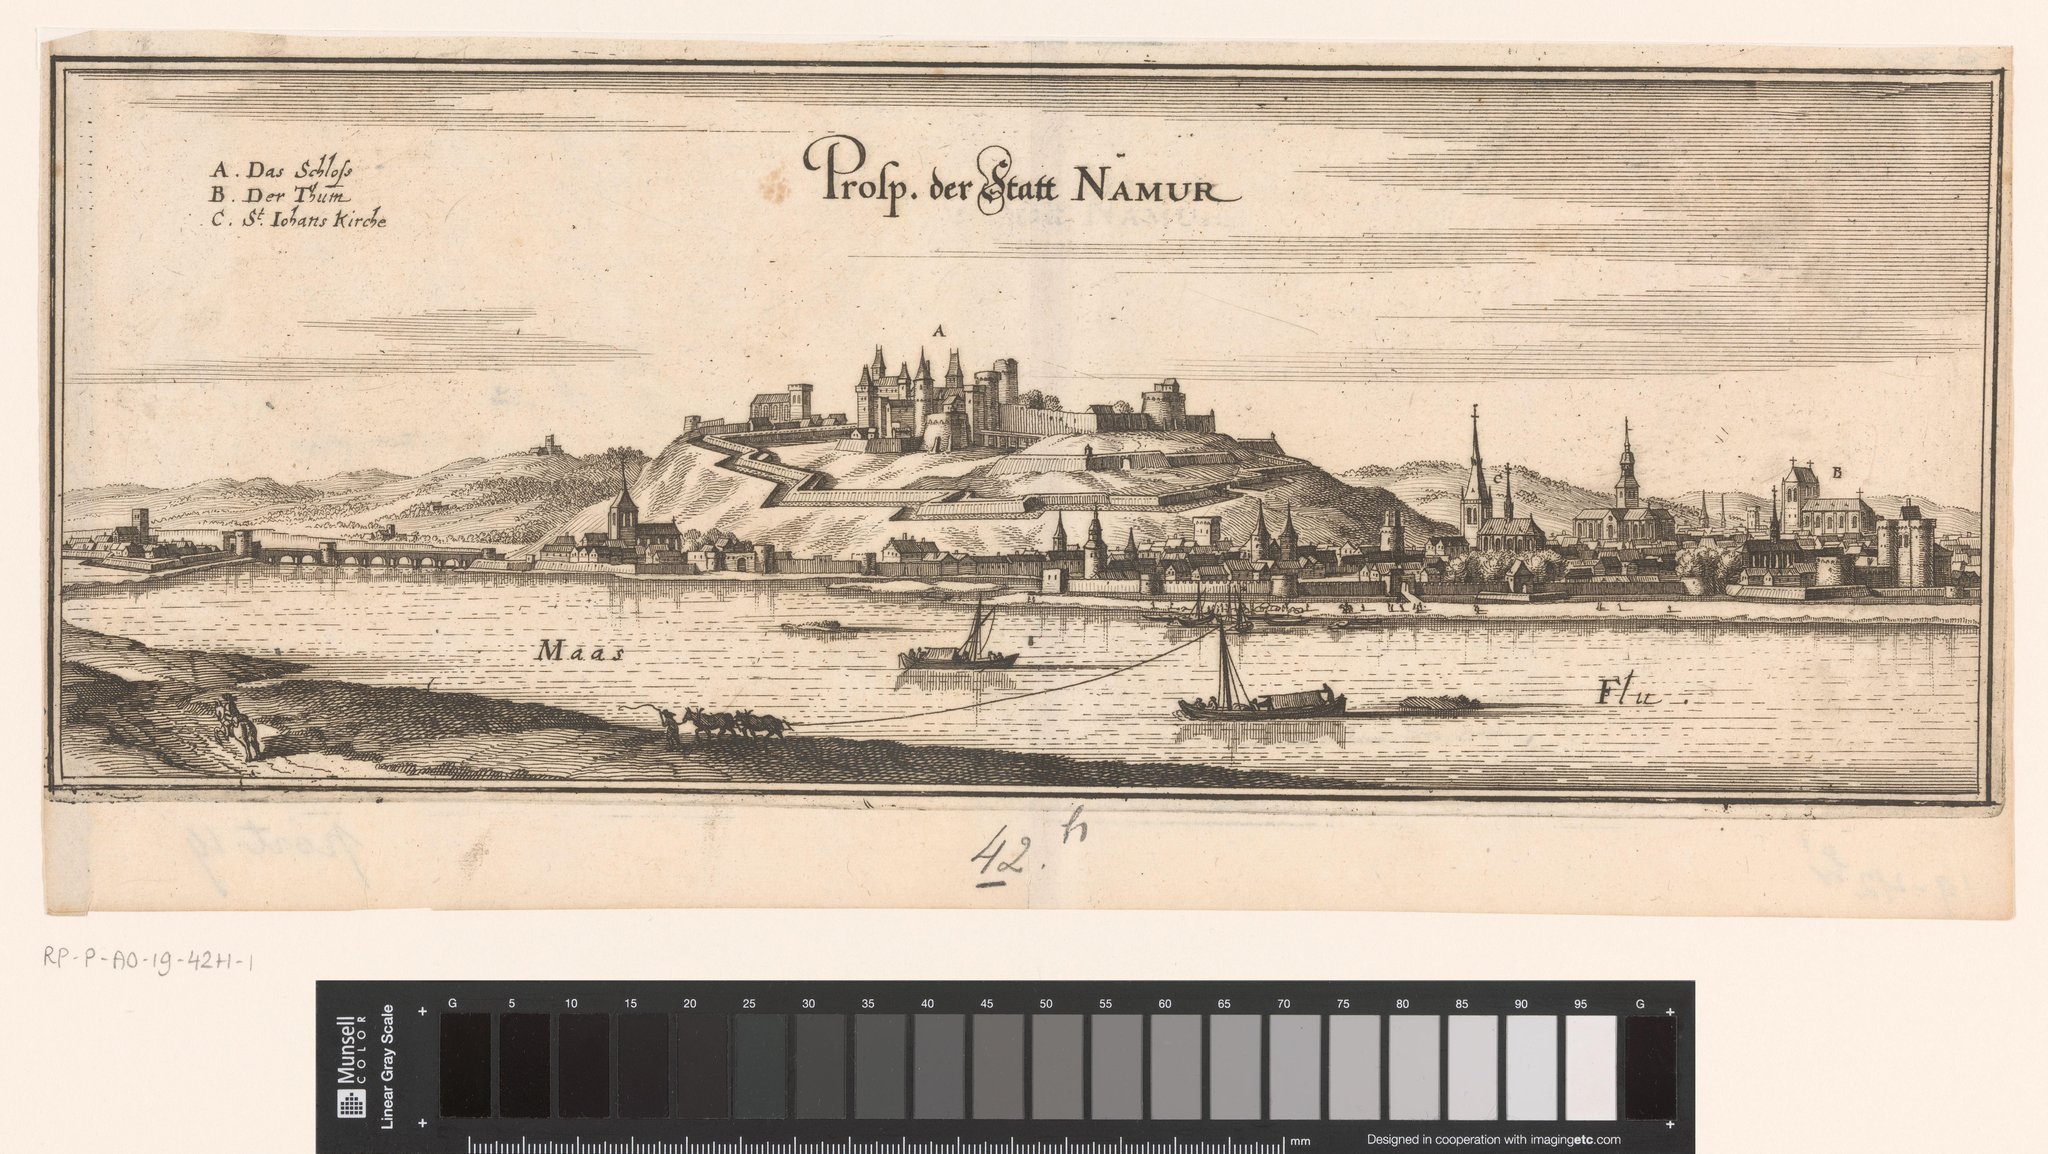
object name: print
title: Gezicht op Namen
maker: caspar merian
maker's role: print maker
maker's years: 1627-1689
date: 1654-1700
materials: paper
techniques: engraving, etching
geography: frankfurt am main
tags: church (exterior), prospect of city, town panorama, silhouette of city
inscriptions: collector's mark: Lugt 2228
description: Prent gebruikt in: Zeiller, Martin. M.Z. Topographia Circuli Burgundici Oder Beschreibung une Eigentliche Abbildung der Vornehmsten Örter in dem Hochlöblichen Burgund- un Niderlandischen Crayse. Frankfurt am Main: Caspar Merian, 1654. Of in: Zeiller, Martin. M. Z. Topographia Germaniae-Inferioris vel Circuli-Burgundici, das ist Beschreibung (…). Frankfurt am Main: Caspar Merian, 1659. Of in een van de twee latere uitgaven van deze publicatie die, hoewel het jaar 1659 erin staat vermeld als jaar van uitgave, zijn uitgegeven in respectievelijk ca. 1670 en ca. 1700.